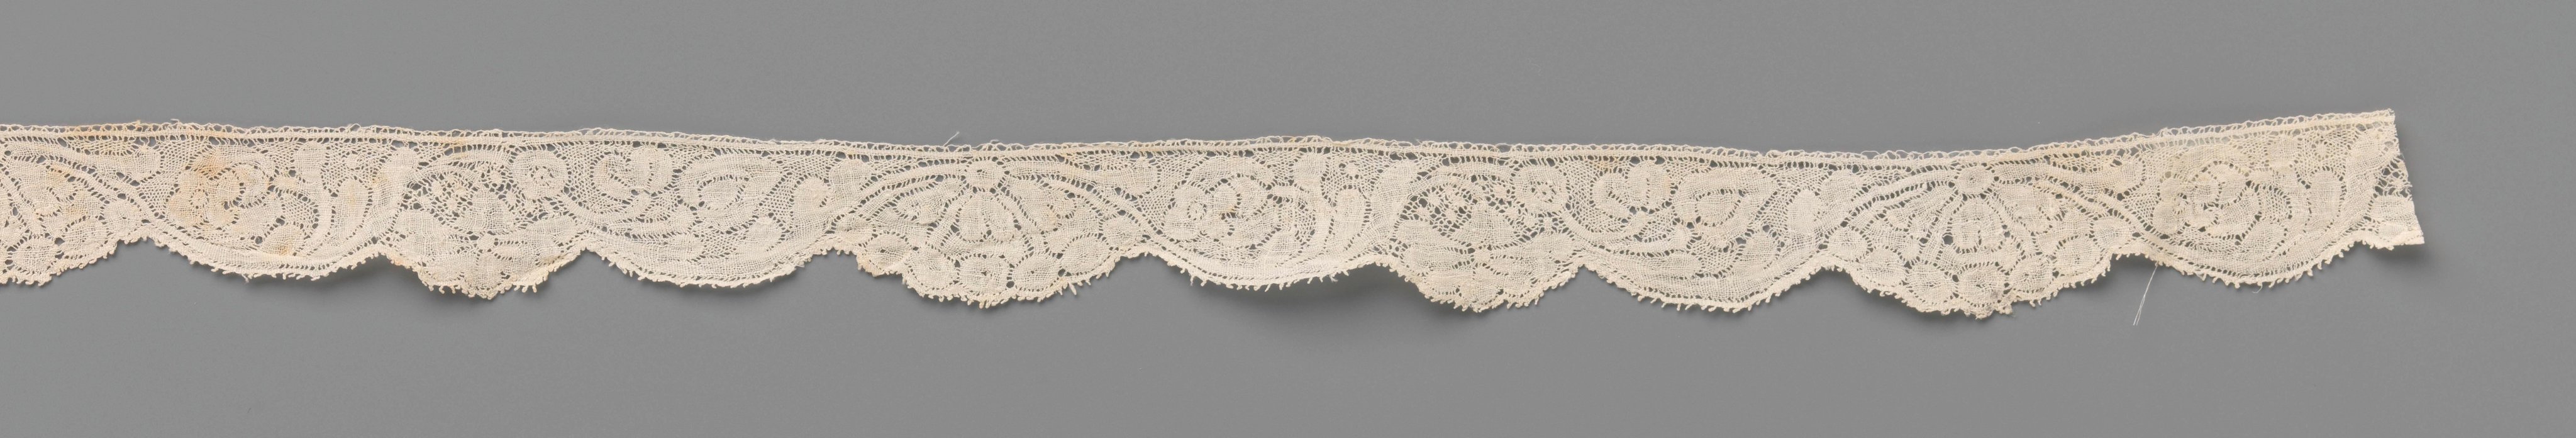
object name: strip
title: Strook kloskant met anjer en peervormige bloem tussen hartjeswaaiers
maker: Anonymous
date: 1725-1749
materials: linen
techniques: lace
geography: southern netherlands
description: Strook naturelkleurige kloskant, Binche-kant. Het zich herhalende en doorlopende patroon bestaat uit een golvende bladrank, die de vorm van de schulpen bepaald. Onder en boven de golftoppen bevinden zich om en om een waaier met hartjes, een peervormige bloem, een hangende anjer en een peervormige bloem met een vierlobbig rozetbloempje in de top. De motieven zijn met elkaar verbonden door netslagvullingen. De motieven zijn gemaakt in linnenslag met uitsparingen en opengewerkte randjes. Boven de hangende anjer is een siergrond met sneeuwvlokken toegepast. De geschulpte onderzijde is voorzien van picots. De bovenzijde is recht afgewerkt.